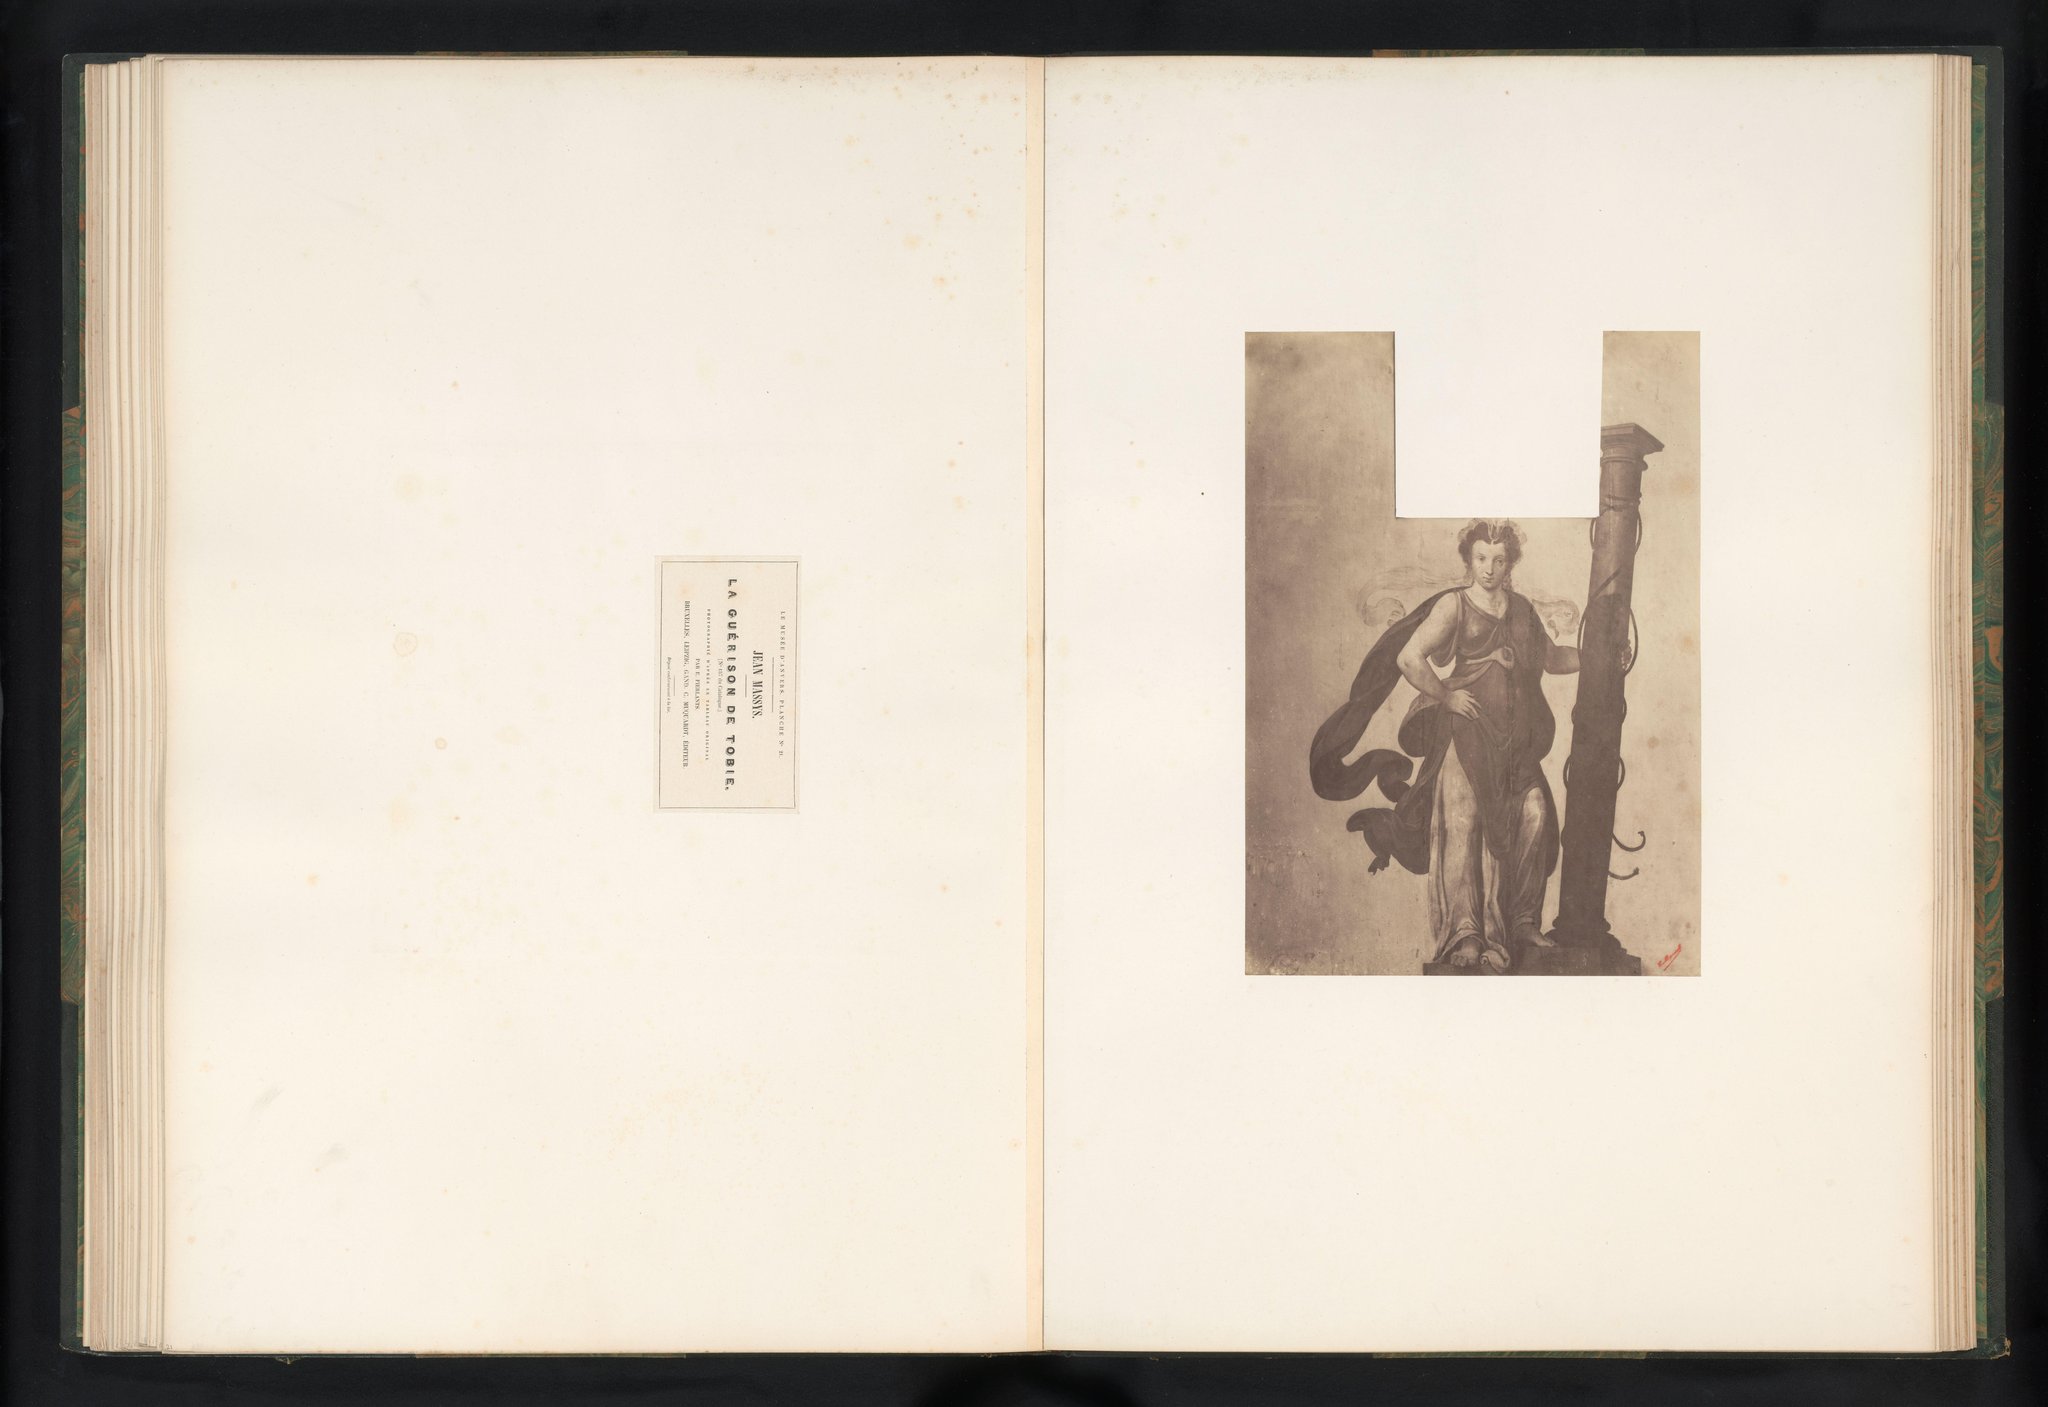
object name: photograph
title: Fotoreproductie van Sibille met kolom door Lambert van Noort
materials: photographic support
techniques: albumen print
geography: brussels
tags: sibyls